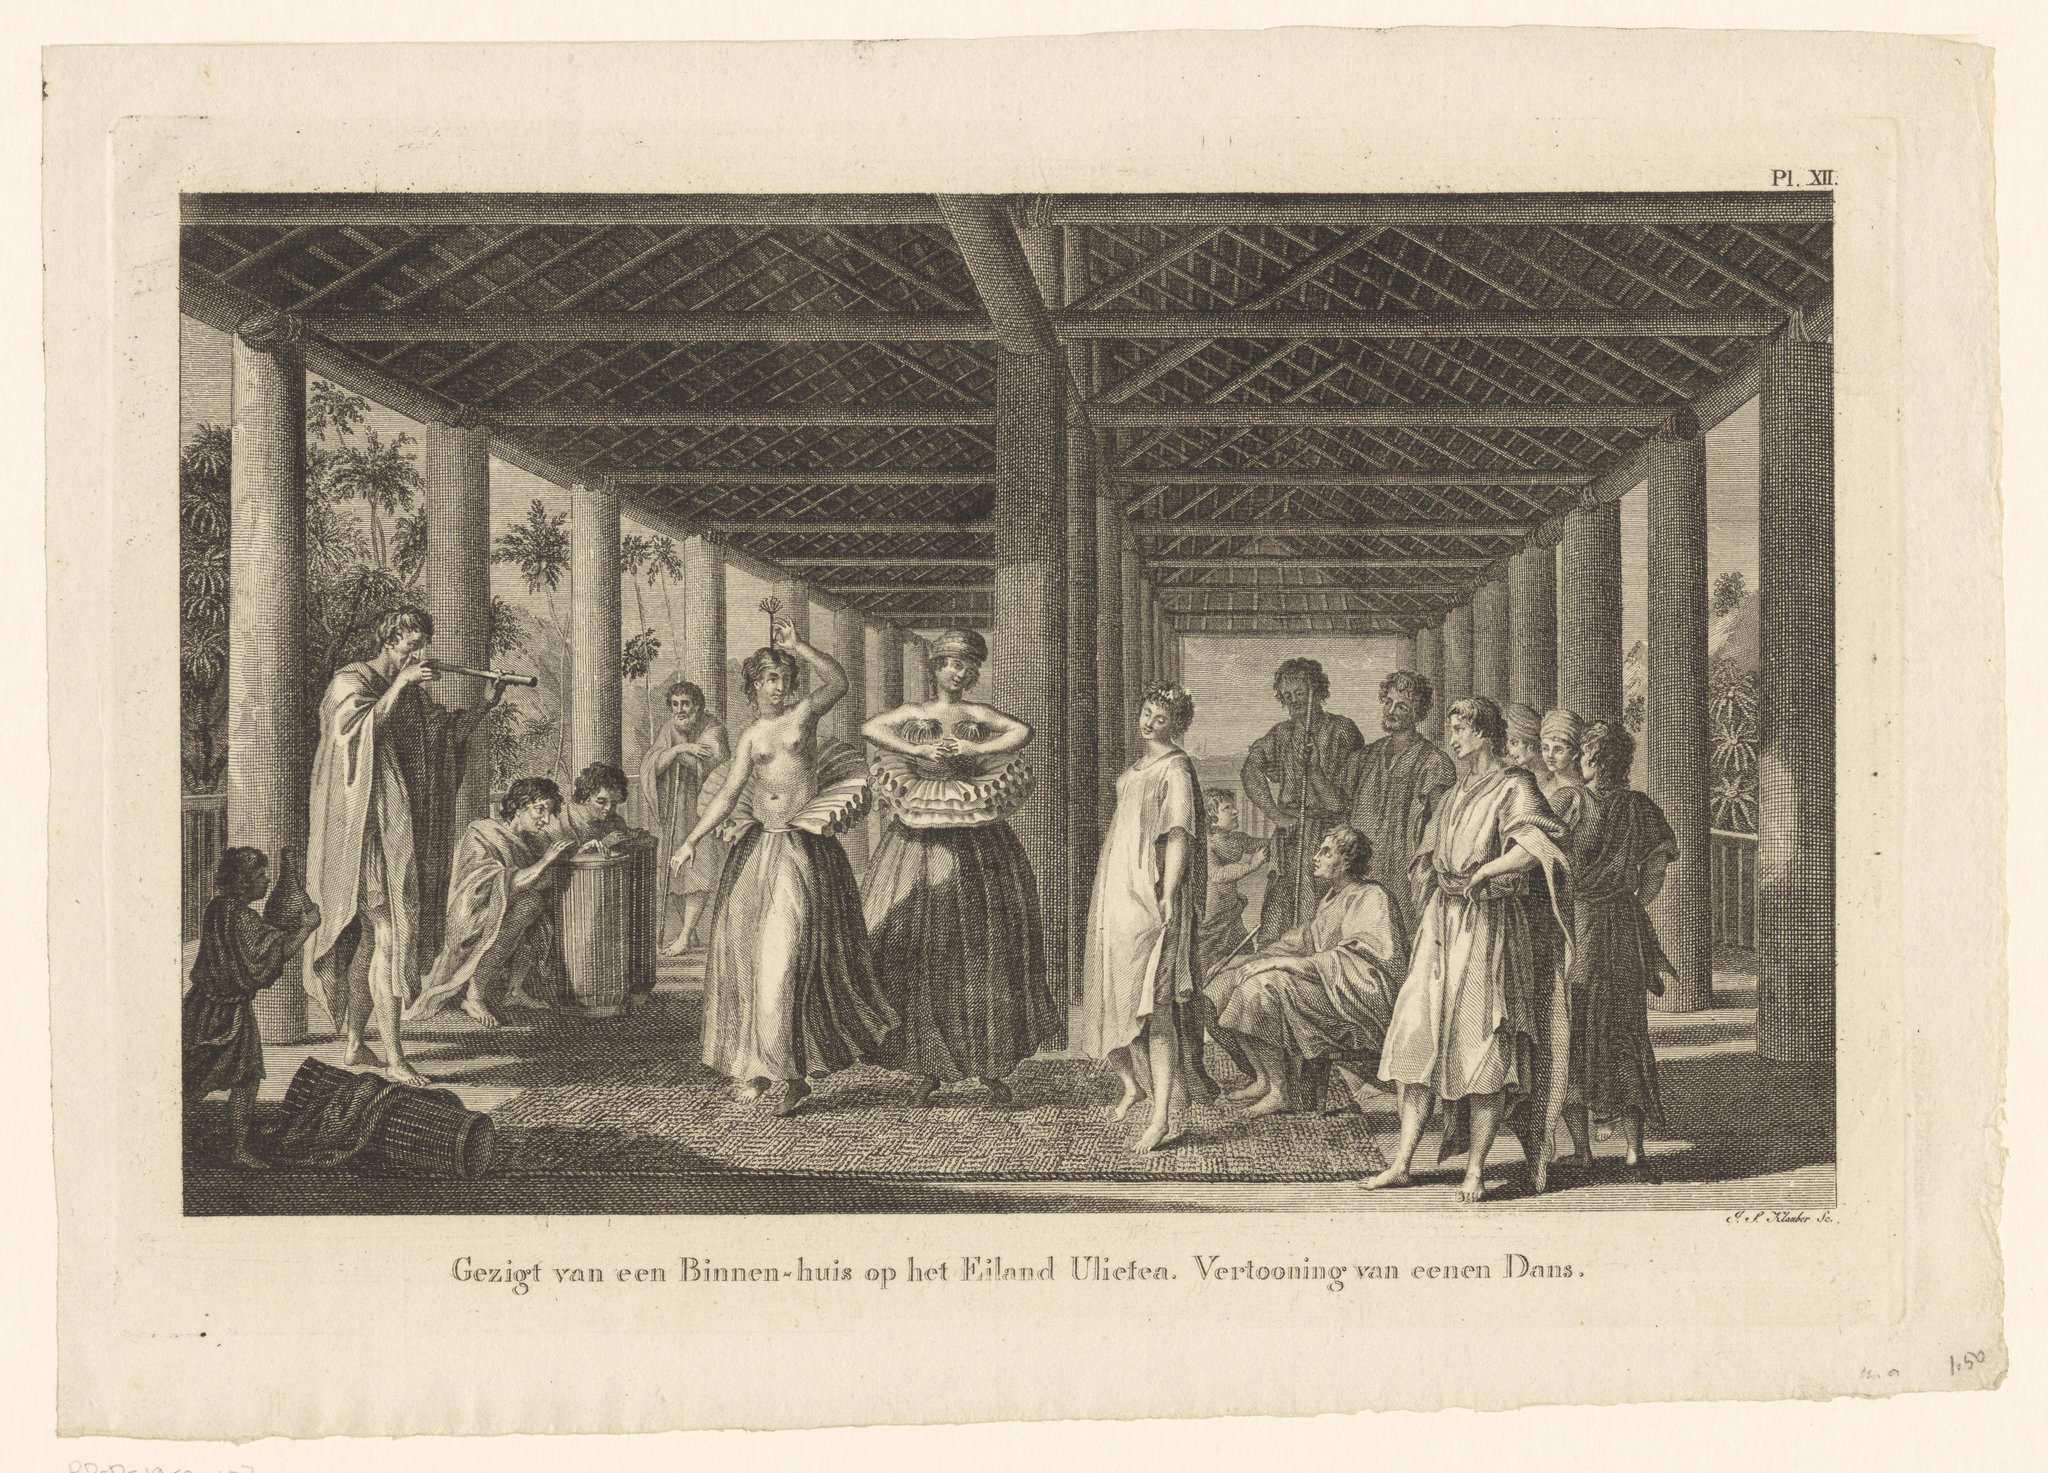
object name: print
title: Dansuitvoering onder een overkapping op het eiland Raiatea in Frans-Polynesië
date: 1797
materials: paper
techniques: engraving, etching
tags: interior ~ representation of a building, group of women (folk dancing), french polynesia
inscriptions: number: ‘XII’, collector's mark: Lugt 2228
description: Deze prent is mogelijk gebruikt in: Cook, James. Reize rondom de Waereld (...) met kaarten en plaaten. [Vertaald uit het Engels door] Jan David Pasteur. Leiden: Honkoop, Amsterdam: Allart, Den Haag: Van Cleef, 1797, dl. 6.